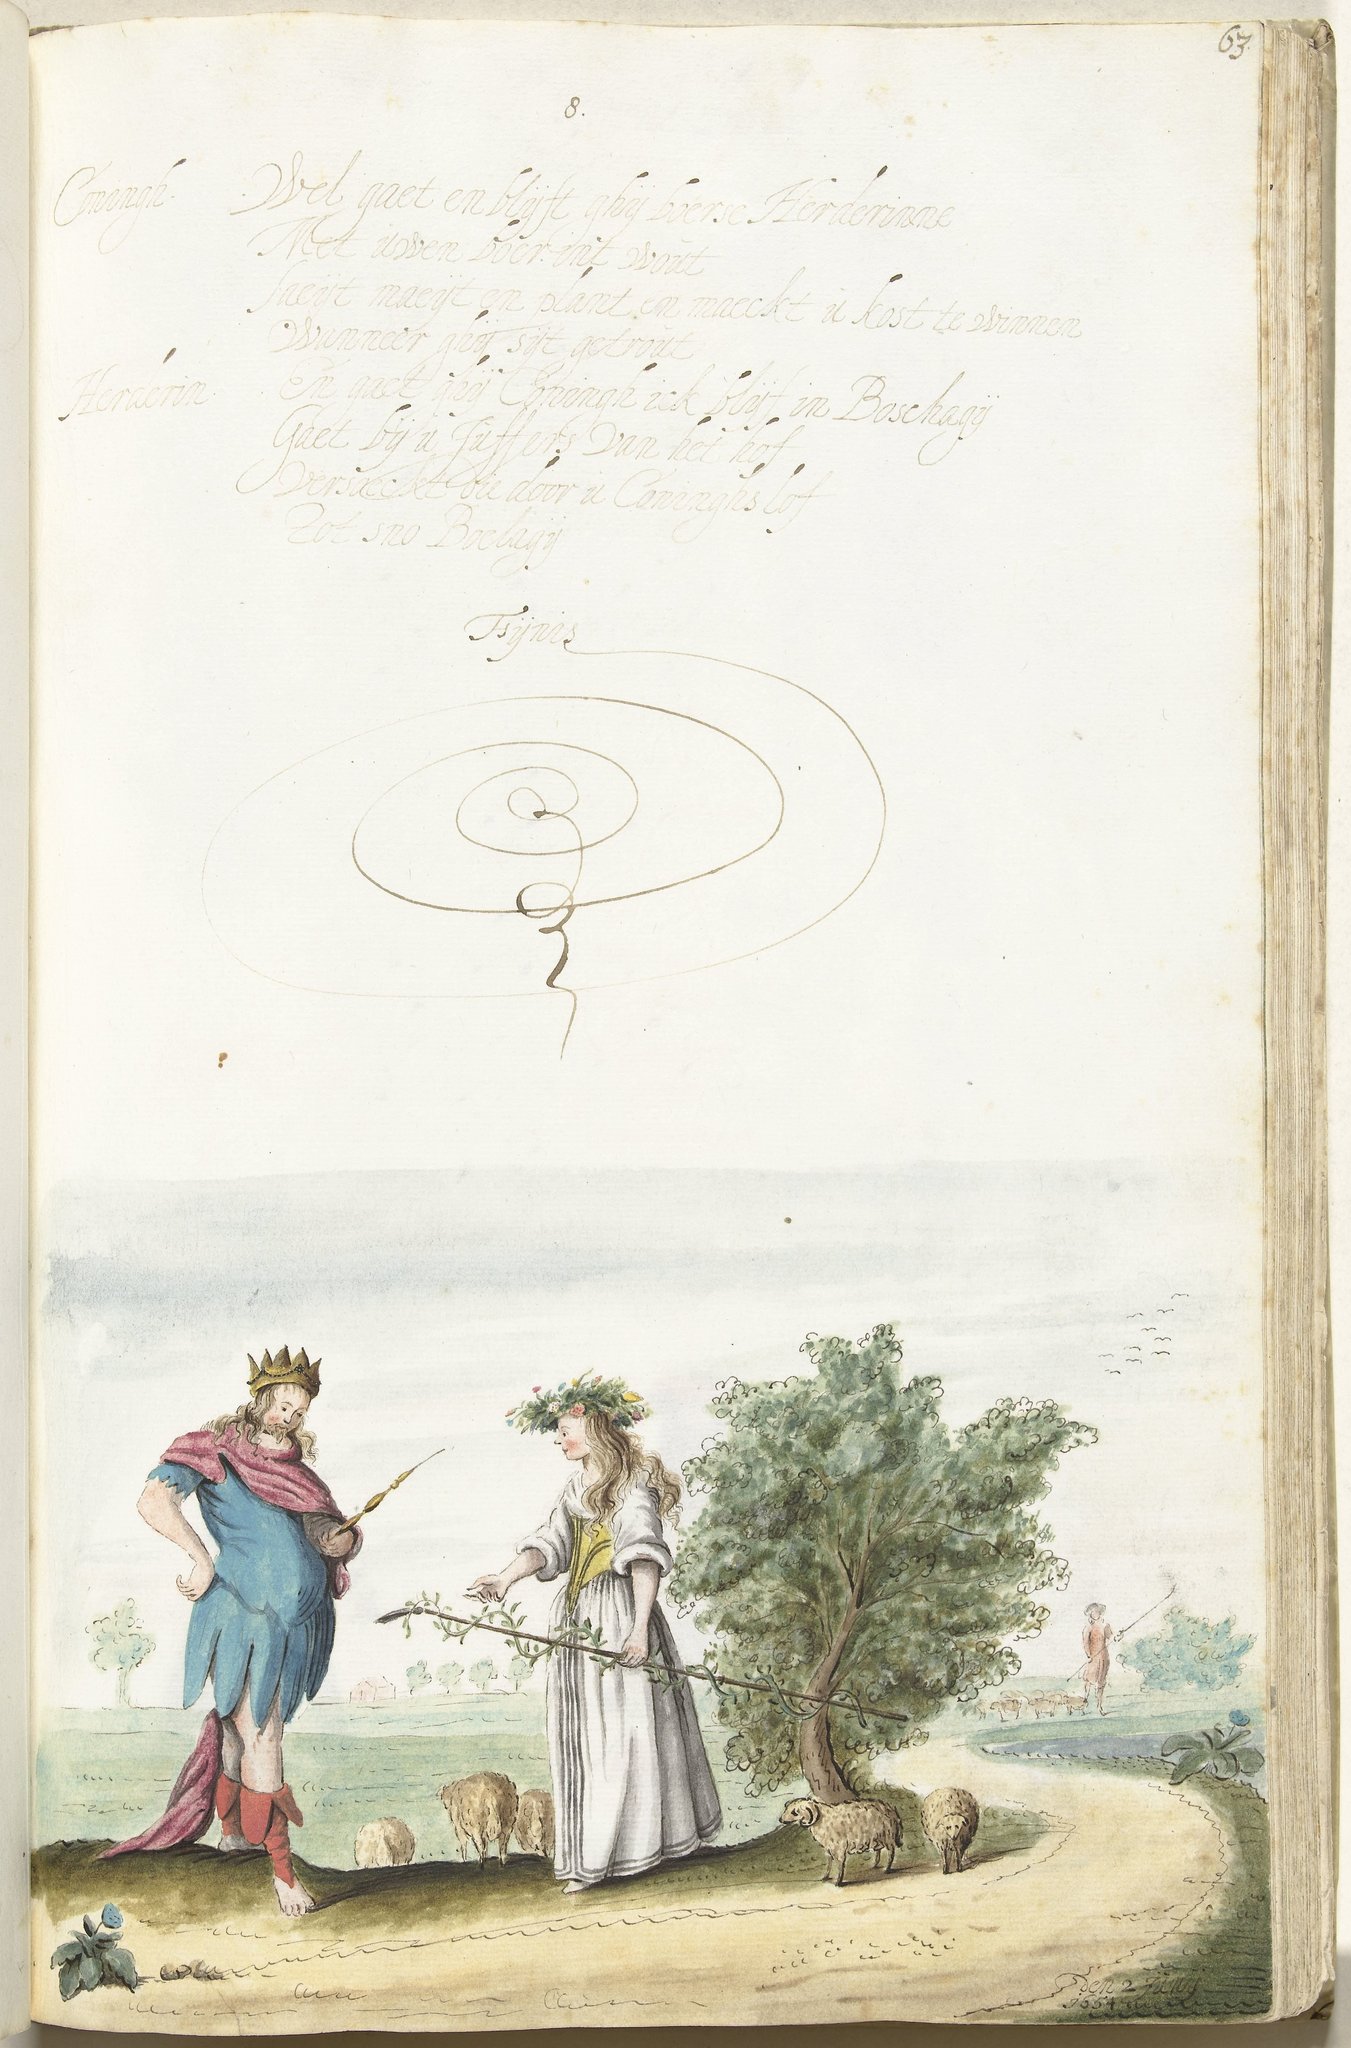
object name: drawing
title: Koning en herderin in gesprek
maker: gesina ter borch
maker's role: draughtsman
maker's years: 1633-1690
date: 1654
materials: ink, paper, watercolor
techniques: brush, calligraphy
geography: zwolle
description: Het gedicht is te vinden in de Haerlemsche Laurier-Krans uit 1643 (p. 42) en in het Utrechts Zang-Prieeltien uit 1649 (I, p. 17-20).